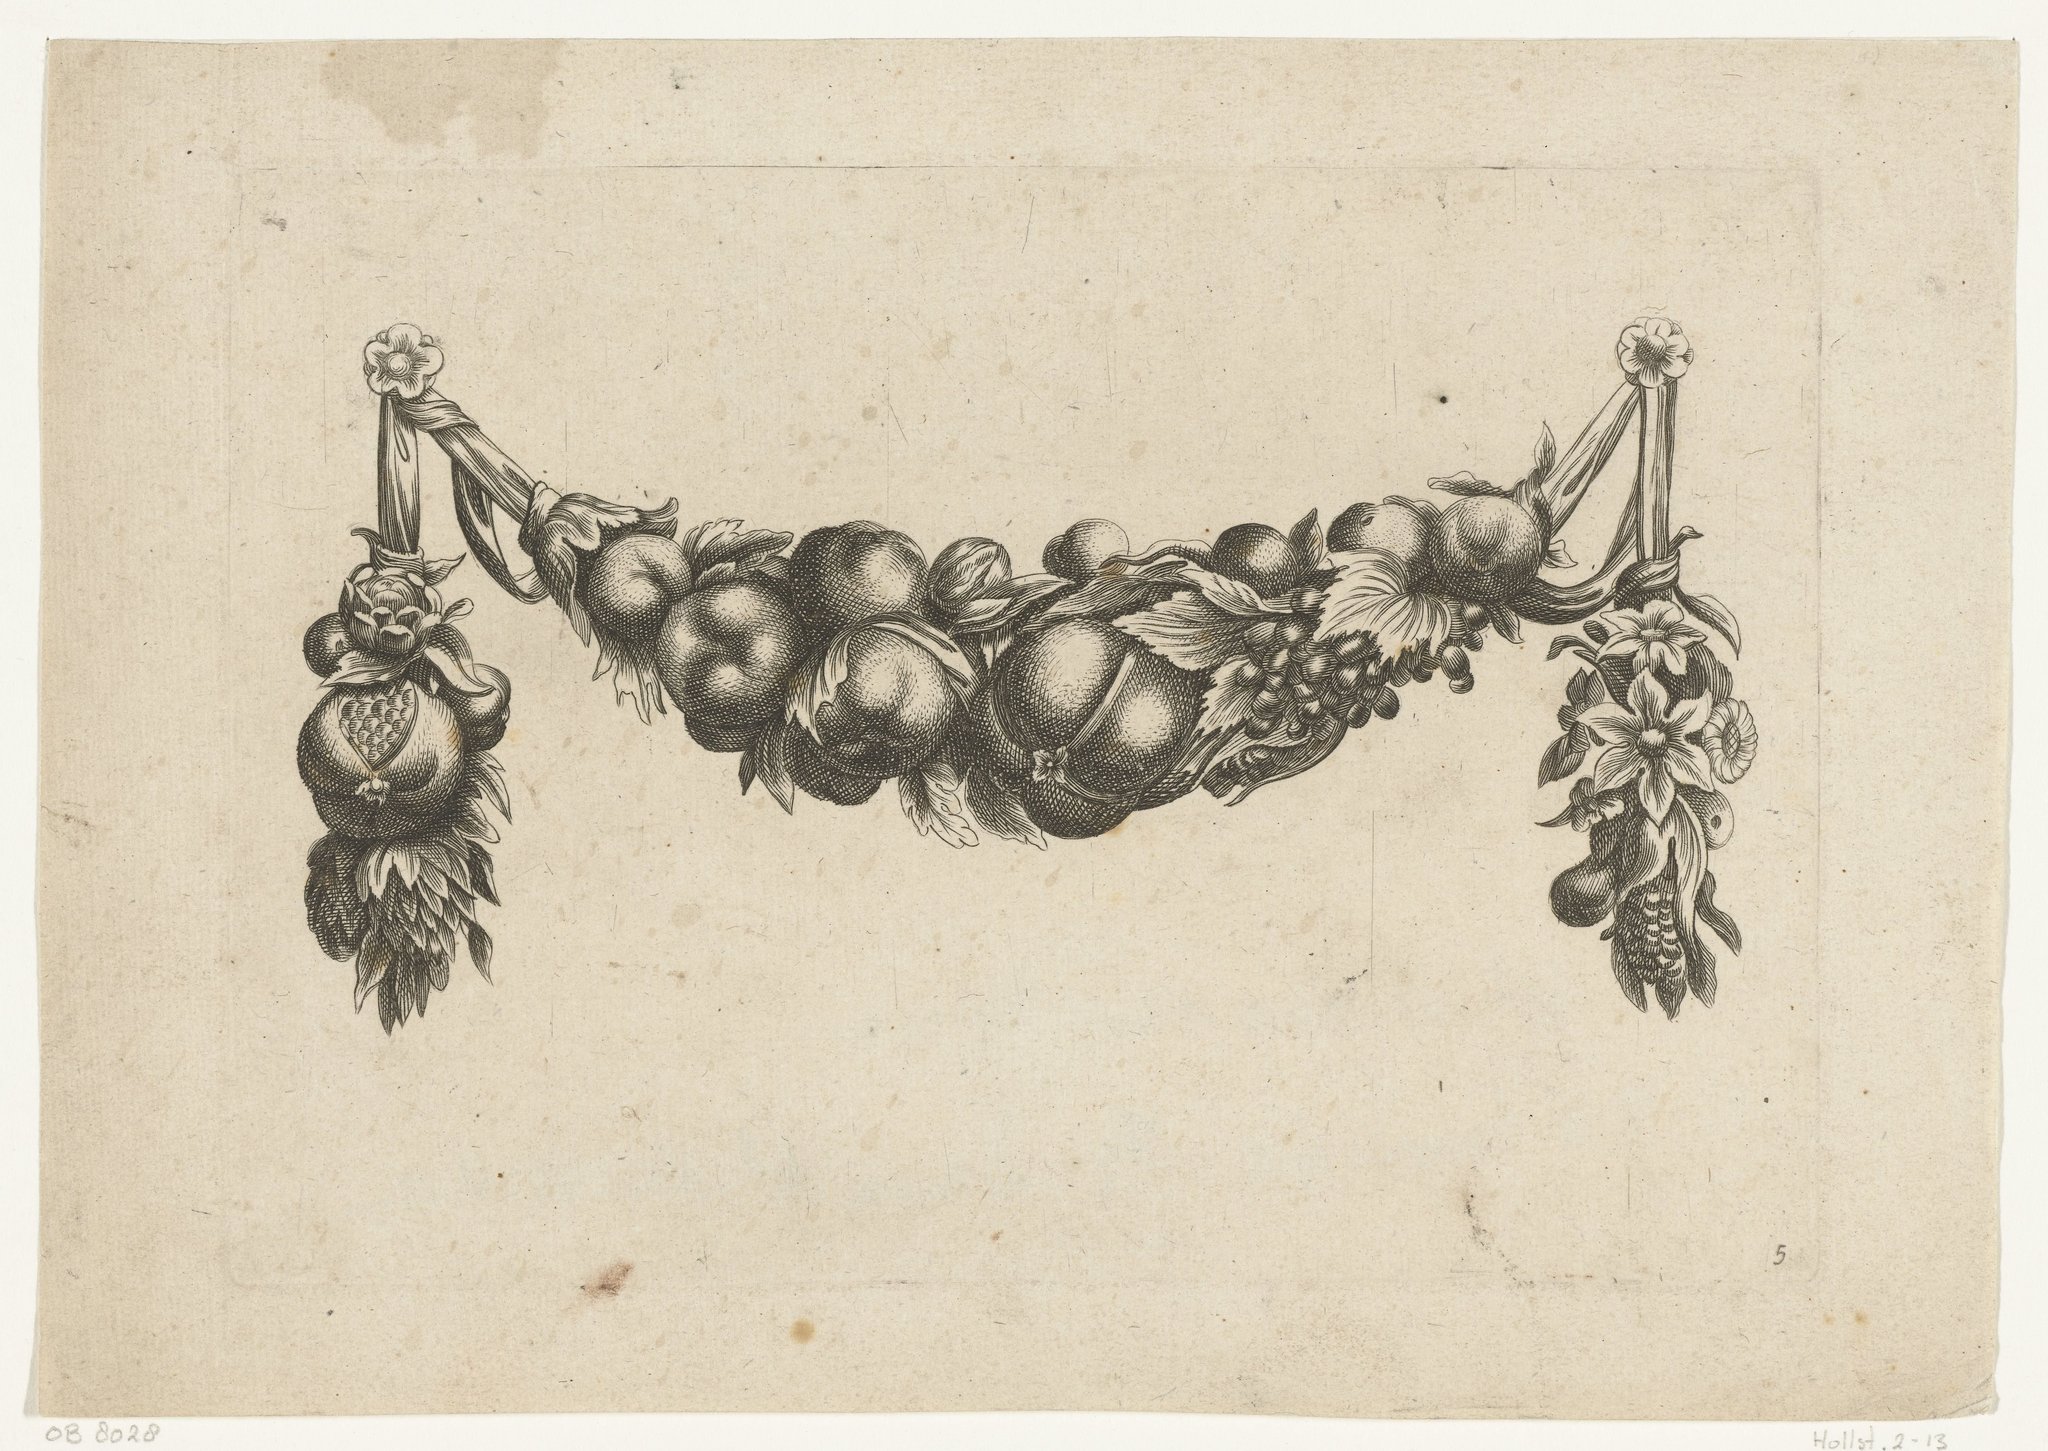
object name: ornament print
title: Verscheide Nieuwe Festonnen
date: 1655-1678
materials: paper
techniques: engraving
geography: amsterdam